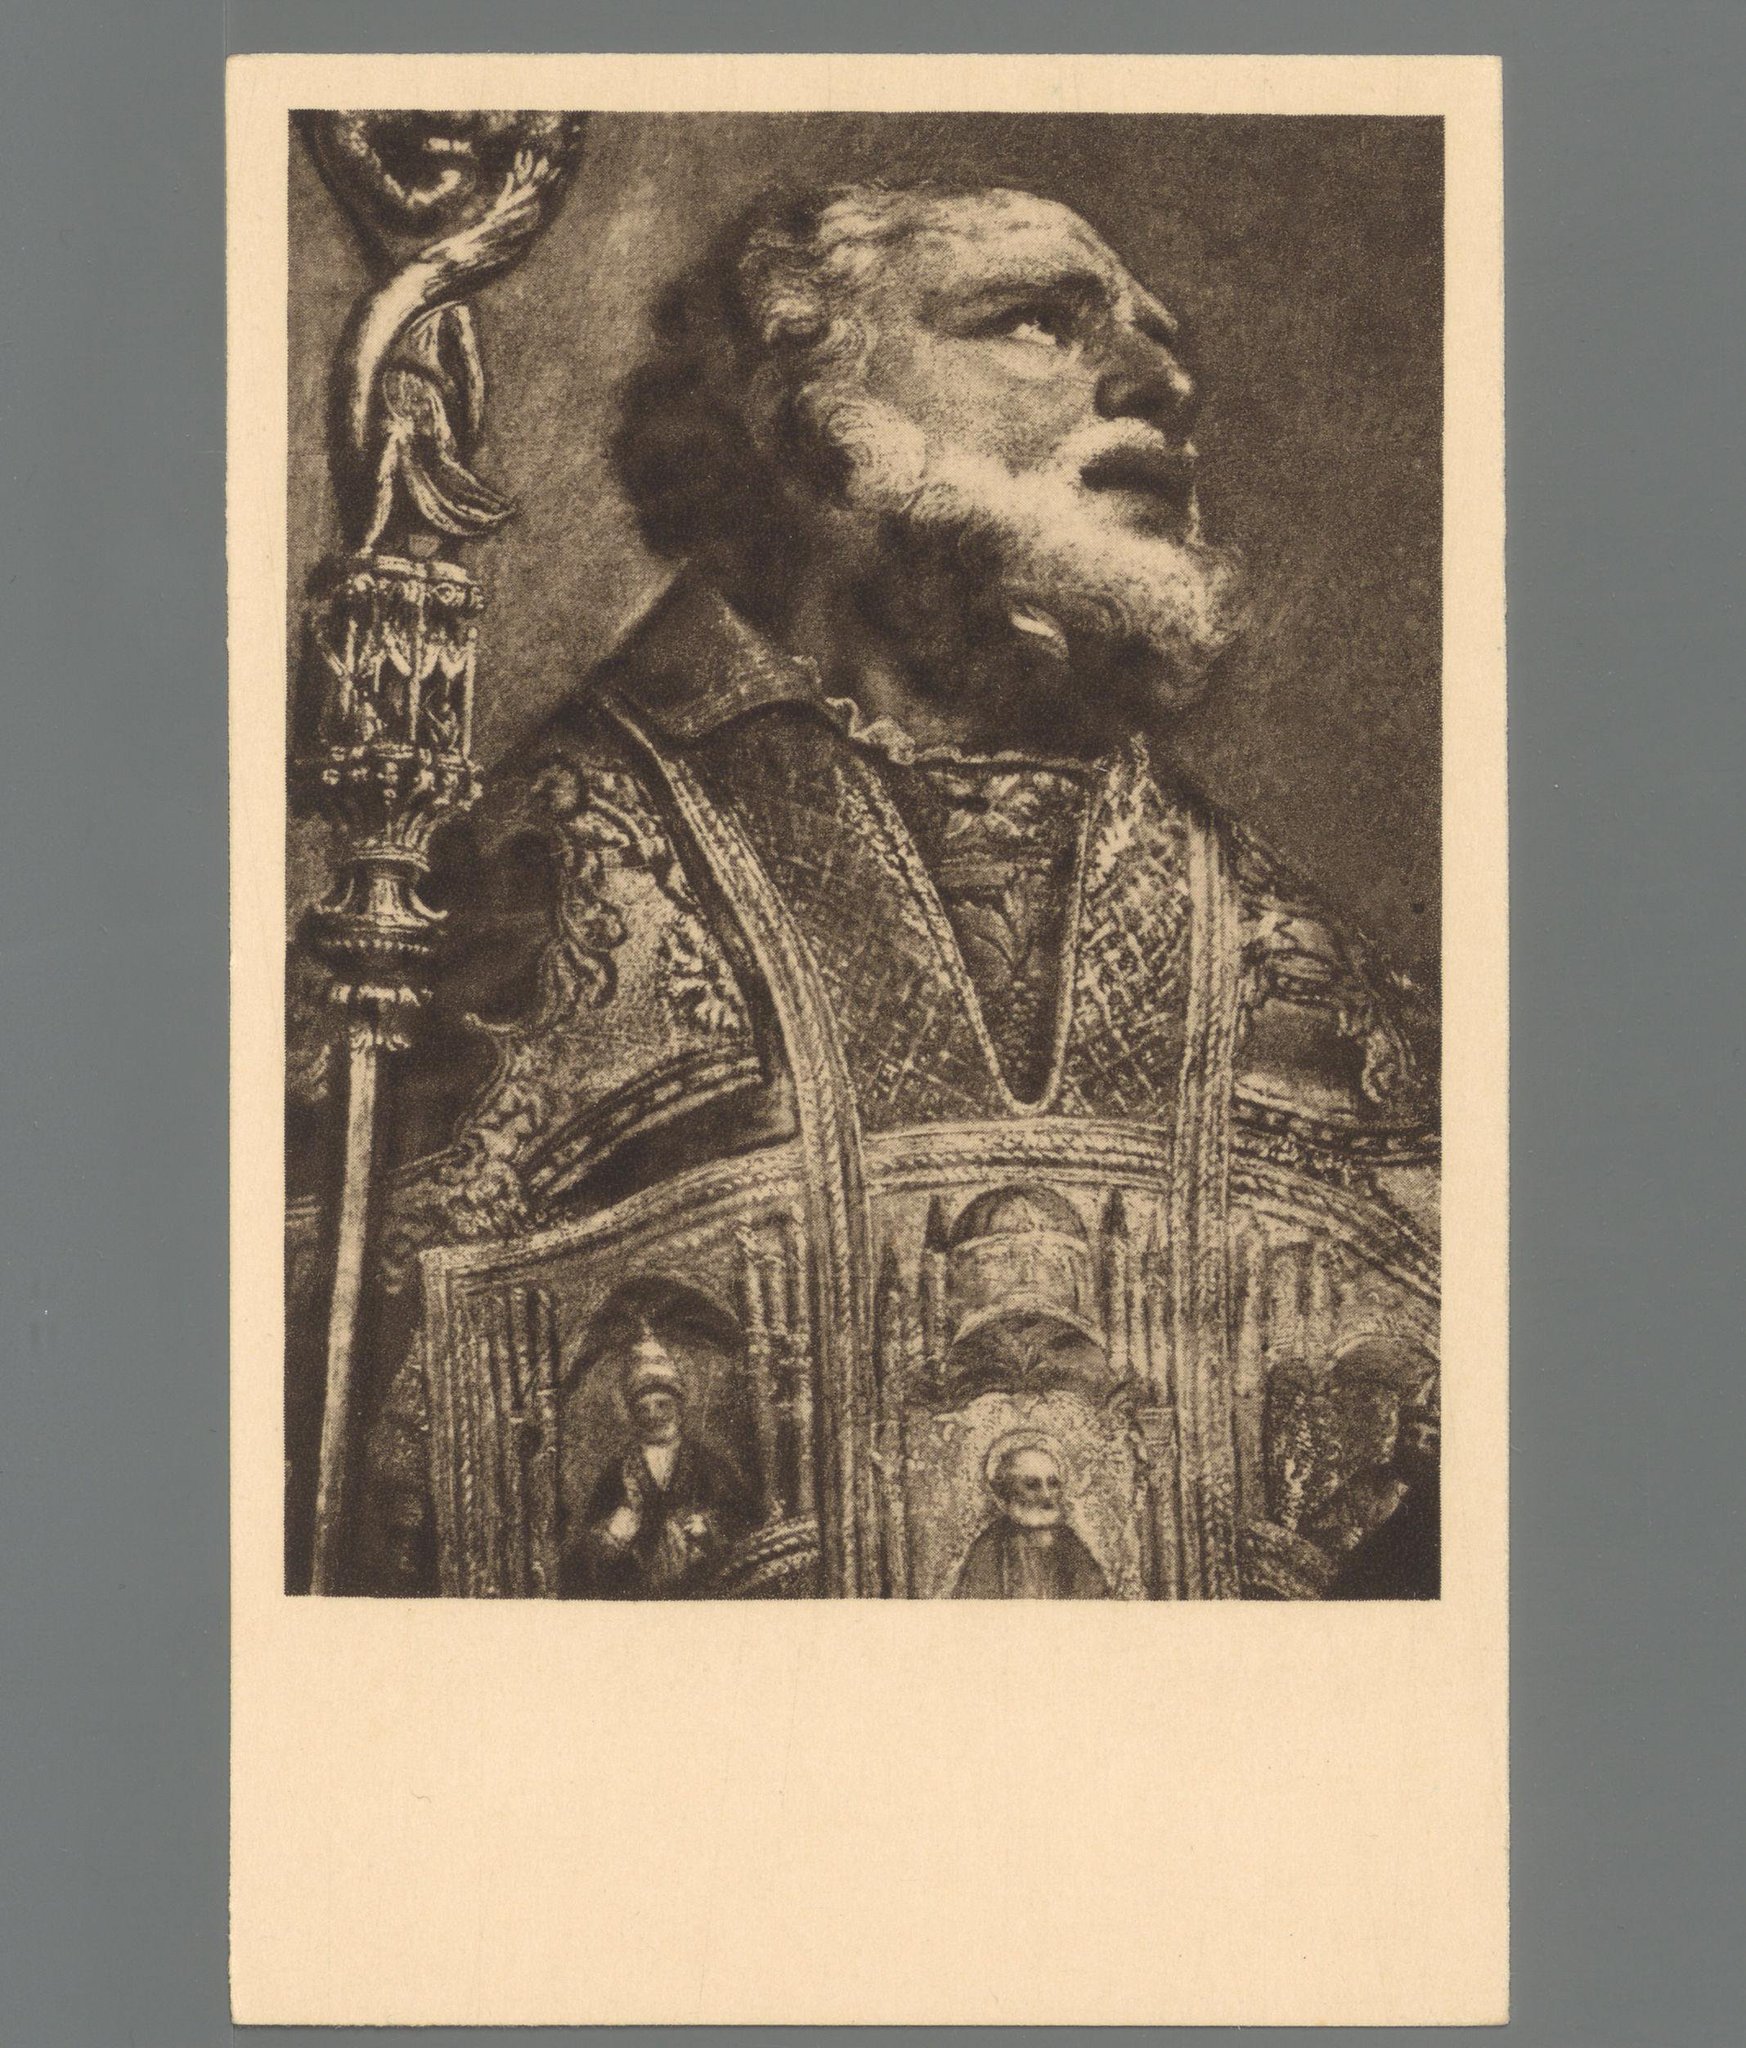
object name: photomechanical print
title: Tiziano Vecellio (1477-1576). De H. Nicolaas (gedeelte) - Rome, Pinacoteca Vaticana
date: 1928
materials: cardboard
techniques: rotogravure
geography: milan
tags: permanent exhibition, museum, picture, painting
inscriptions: collector's mark: ‘AFE v S’